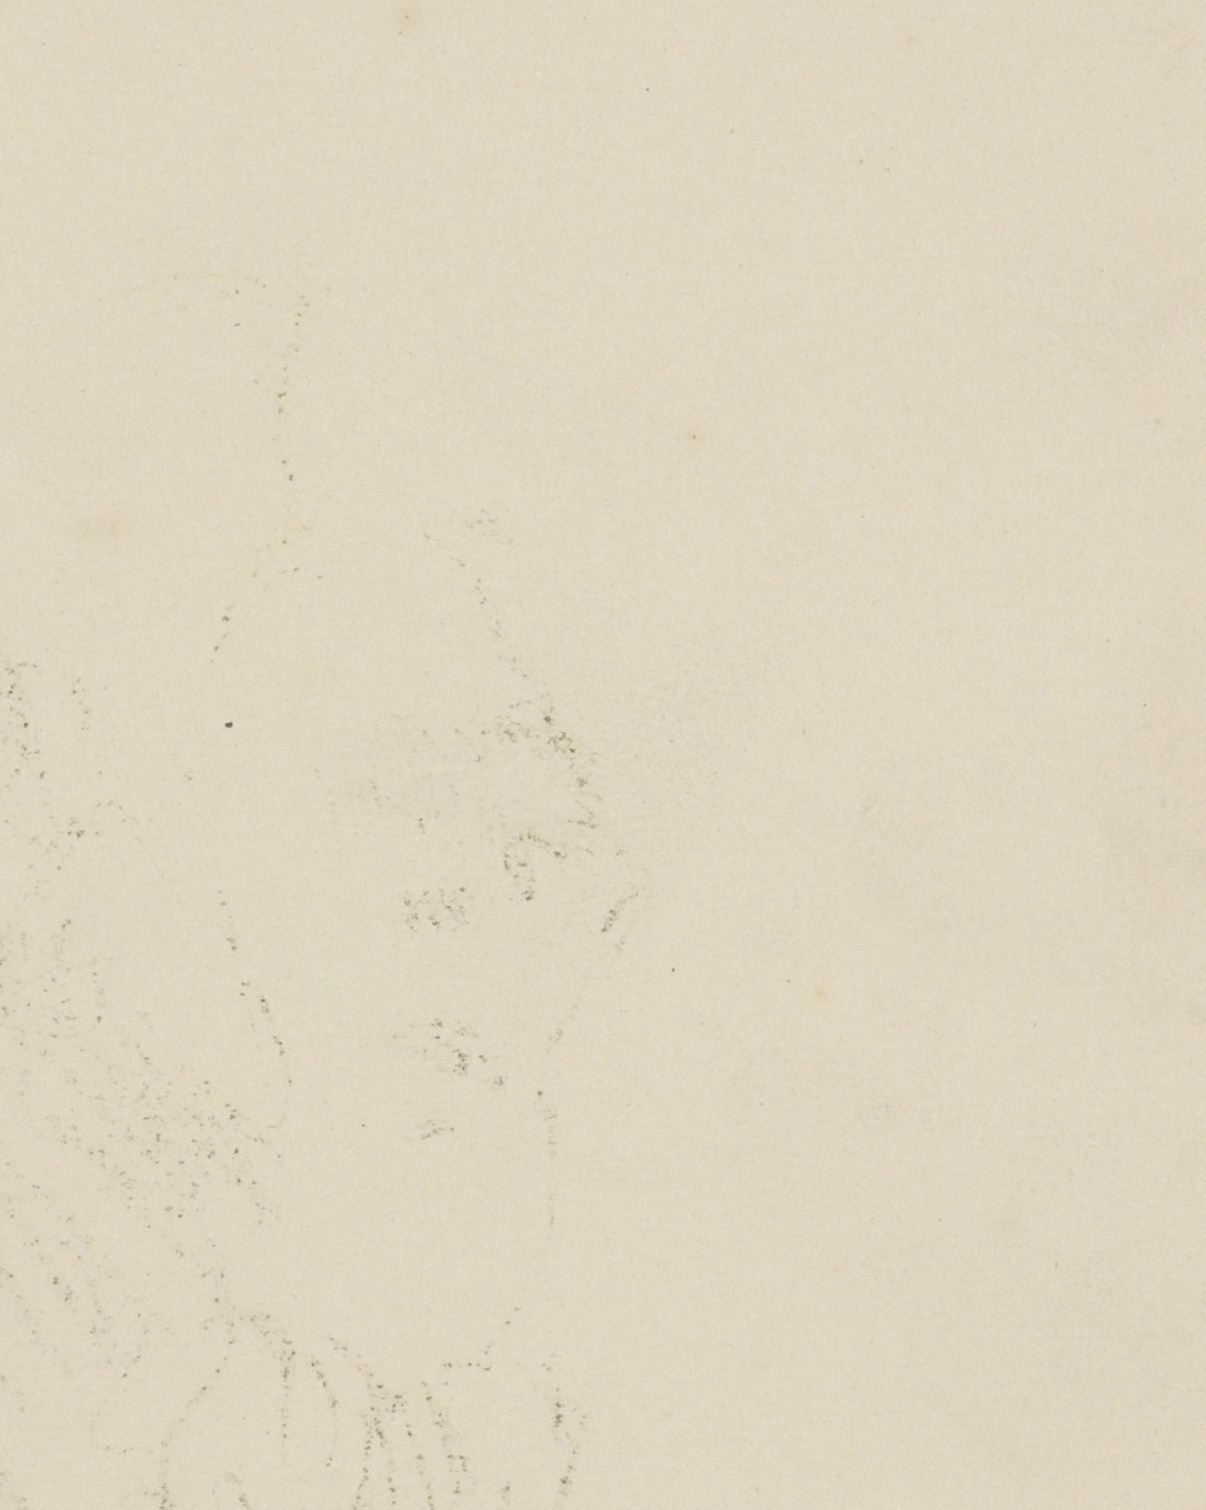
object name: sketchbook leaf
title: Abklatsch van de krijttekening op pagina 54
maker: isaac israels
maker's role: draughtsman, painter, print maker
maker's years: 1865-1934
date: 1886-1903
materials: paper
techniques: printmaking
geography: amsterdam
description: Pagina 55 uit schetsboek XXXII met 92 pagina's.